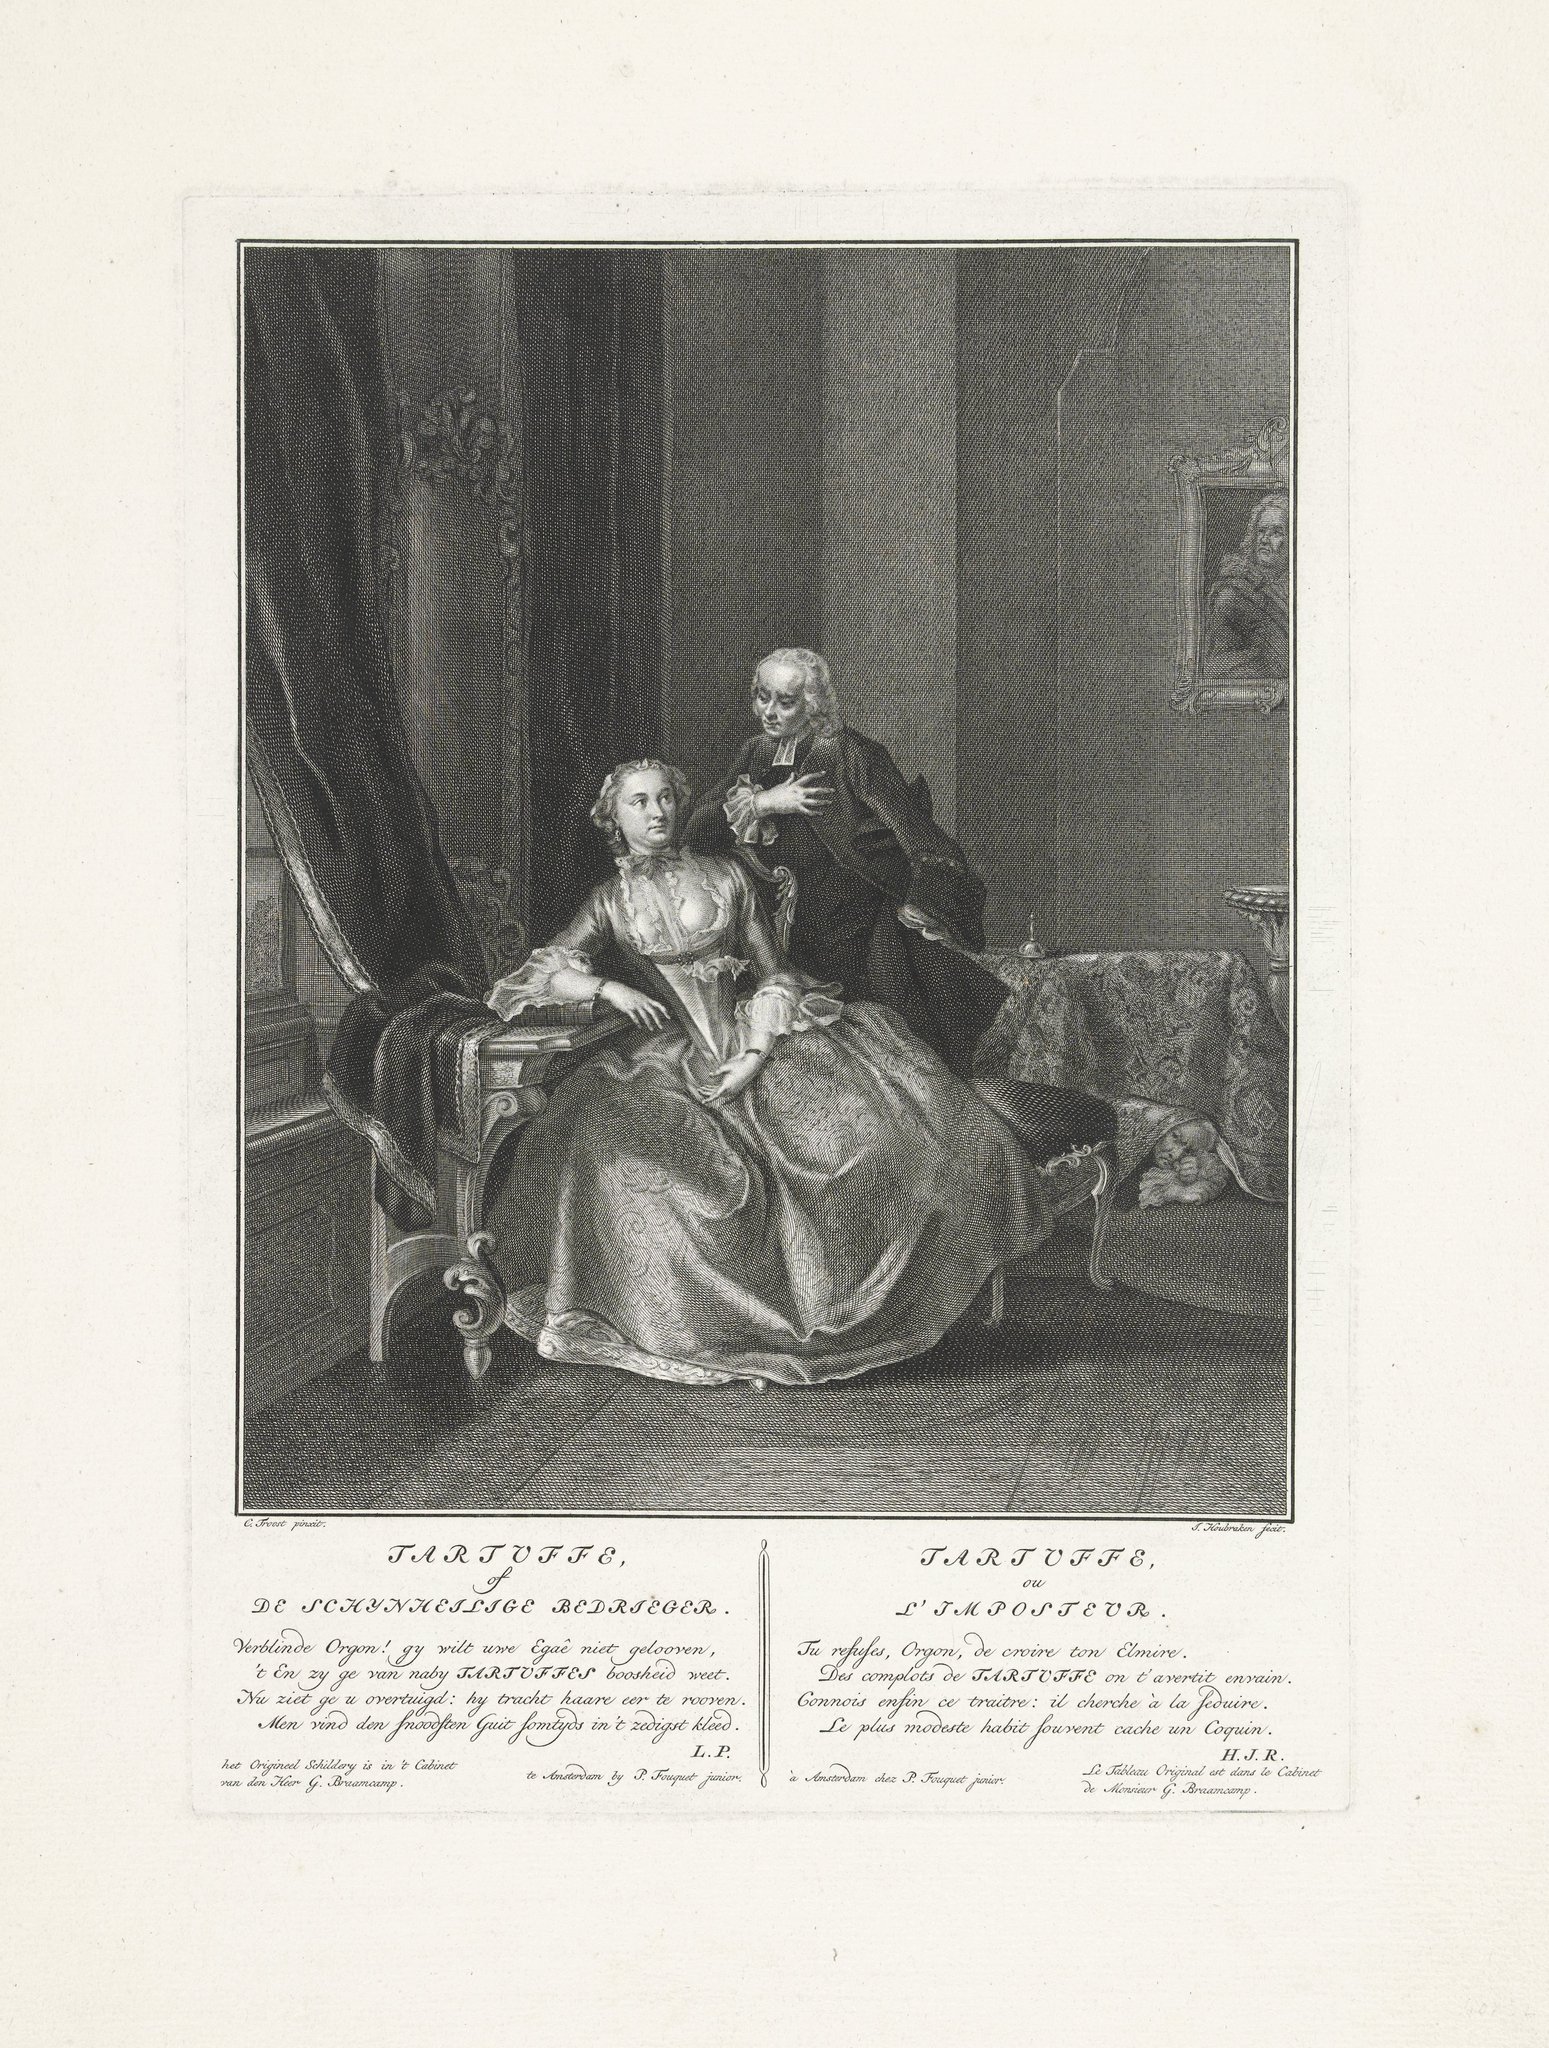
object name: print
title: Tartuffe of de schijnheilige bedrieger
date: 1760-1780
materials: paper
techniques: engraving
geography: amsterdam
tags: dress, gown: robe volante (+ women's clothes), clothes, costume (+ women's clothes), clothes, costume (+ men's clothes), eavesdropper, comedy, intention, purpose, aim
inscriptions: title: ‘Tartuffe / ou / L'Imposteur’, collector's mark: Lugt 2233, signature: ‘C. Troost pinxit’, title: ‘Tartuffe, / of / De Schijnheilige Bedrieger’, caption: ‘Tu refuses, Orgon, de croire ton Elmire....Le plus modeste habit souvent cache un Coquin’, caption: ‘Verblinde orgon ! gij wilt uwe Egae niet geloven...Men vind den snooden Guit somtijds in 't zedigst kleed.’, signature: ‘J. Houbraken fecit’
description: Interieur met een dame, Elmire en een heer, Tartuffe. Op de achtergrond ligt onder een tafel een tweede man, Orgon. Scène uit het toneelstuk Tartuffe van Molière uit 1664: de dame, Elmire, gekleed in een japon met diep decolleté zit op een stoel, haar rechterarm leunend op een dik boek op een tafeltje. Achter haar staat het personage Tartuffe, die haar probeert te verleiden. Op de achtergrond is te zien hoe onder een tafel haar echtgenoot Orgon de twee gade slaat. Elmire overtuigt via deze list haar echtgenoot ervan dat zijn blind vertrouwen in Tartuffe, een geloofsfanaticus, wordt misbruikt.